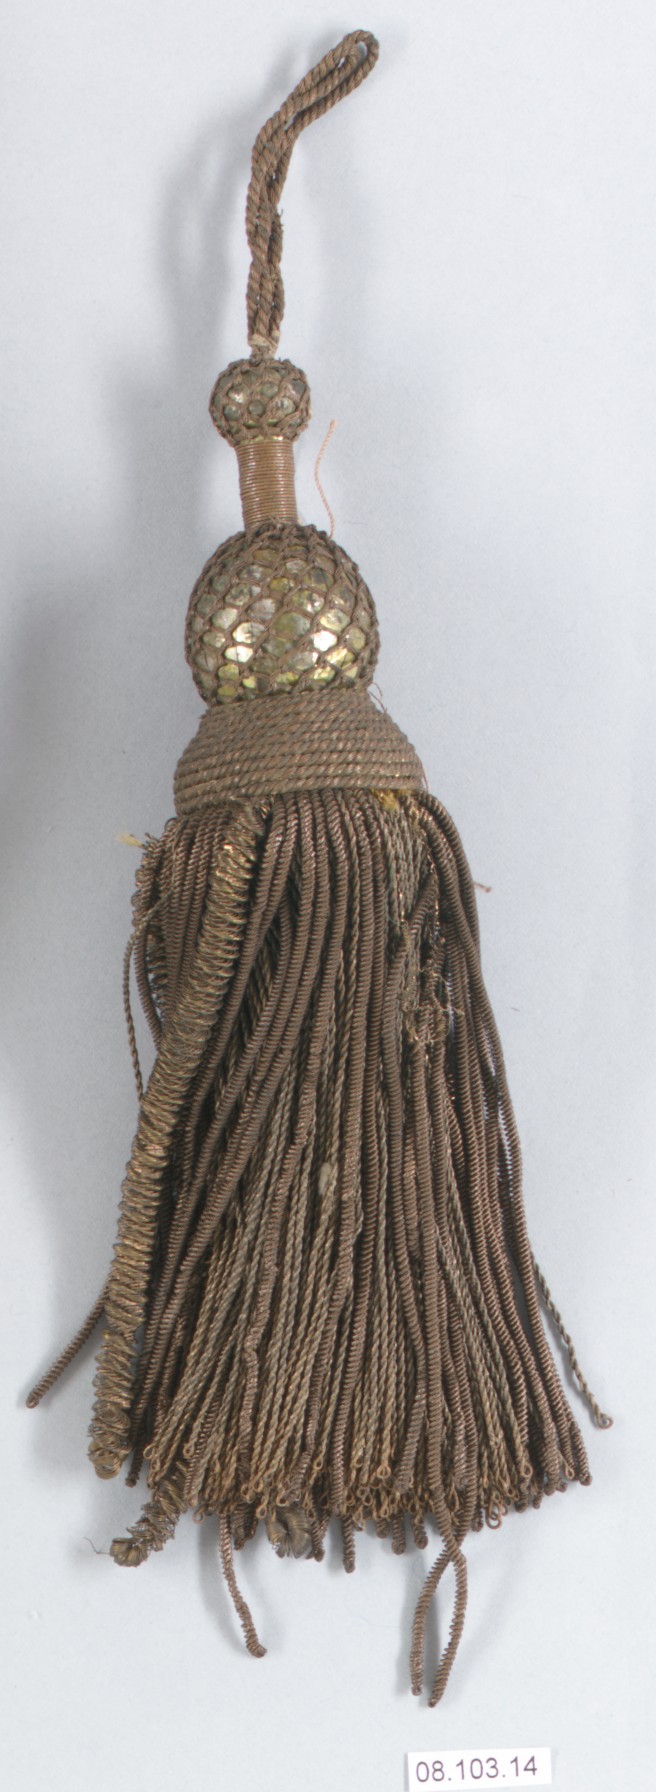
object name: tassel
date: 1701-1900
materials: metal thread